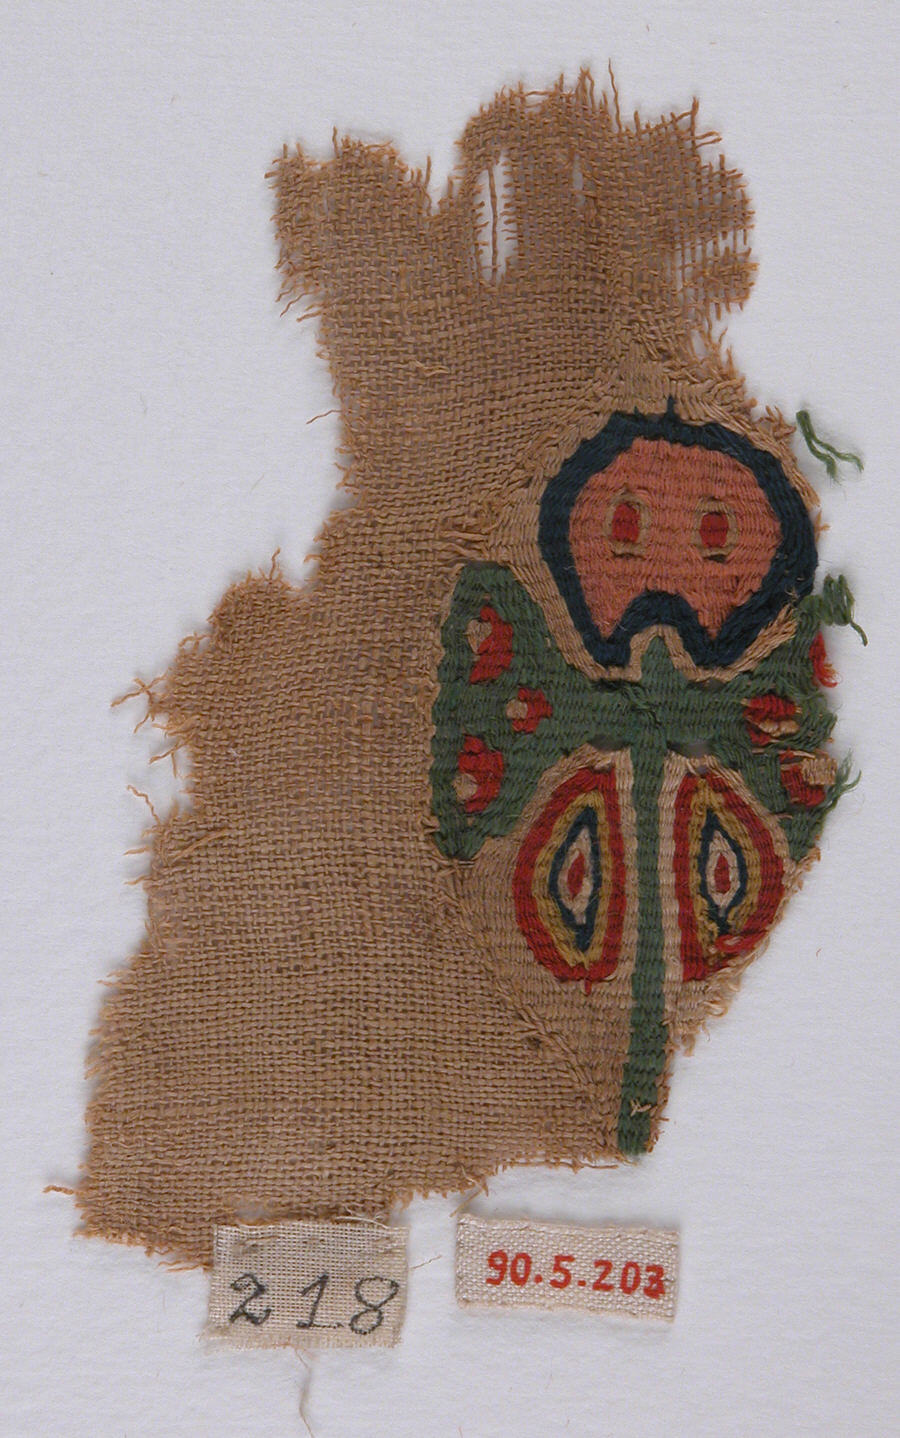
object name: textile fragment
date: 501-700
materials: linen, wool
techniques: weave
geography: egypt